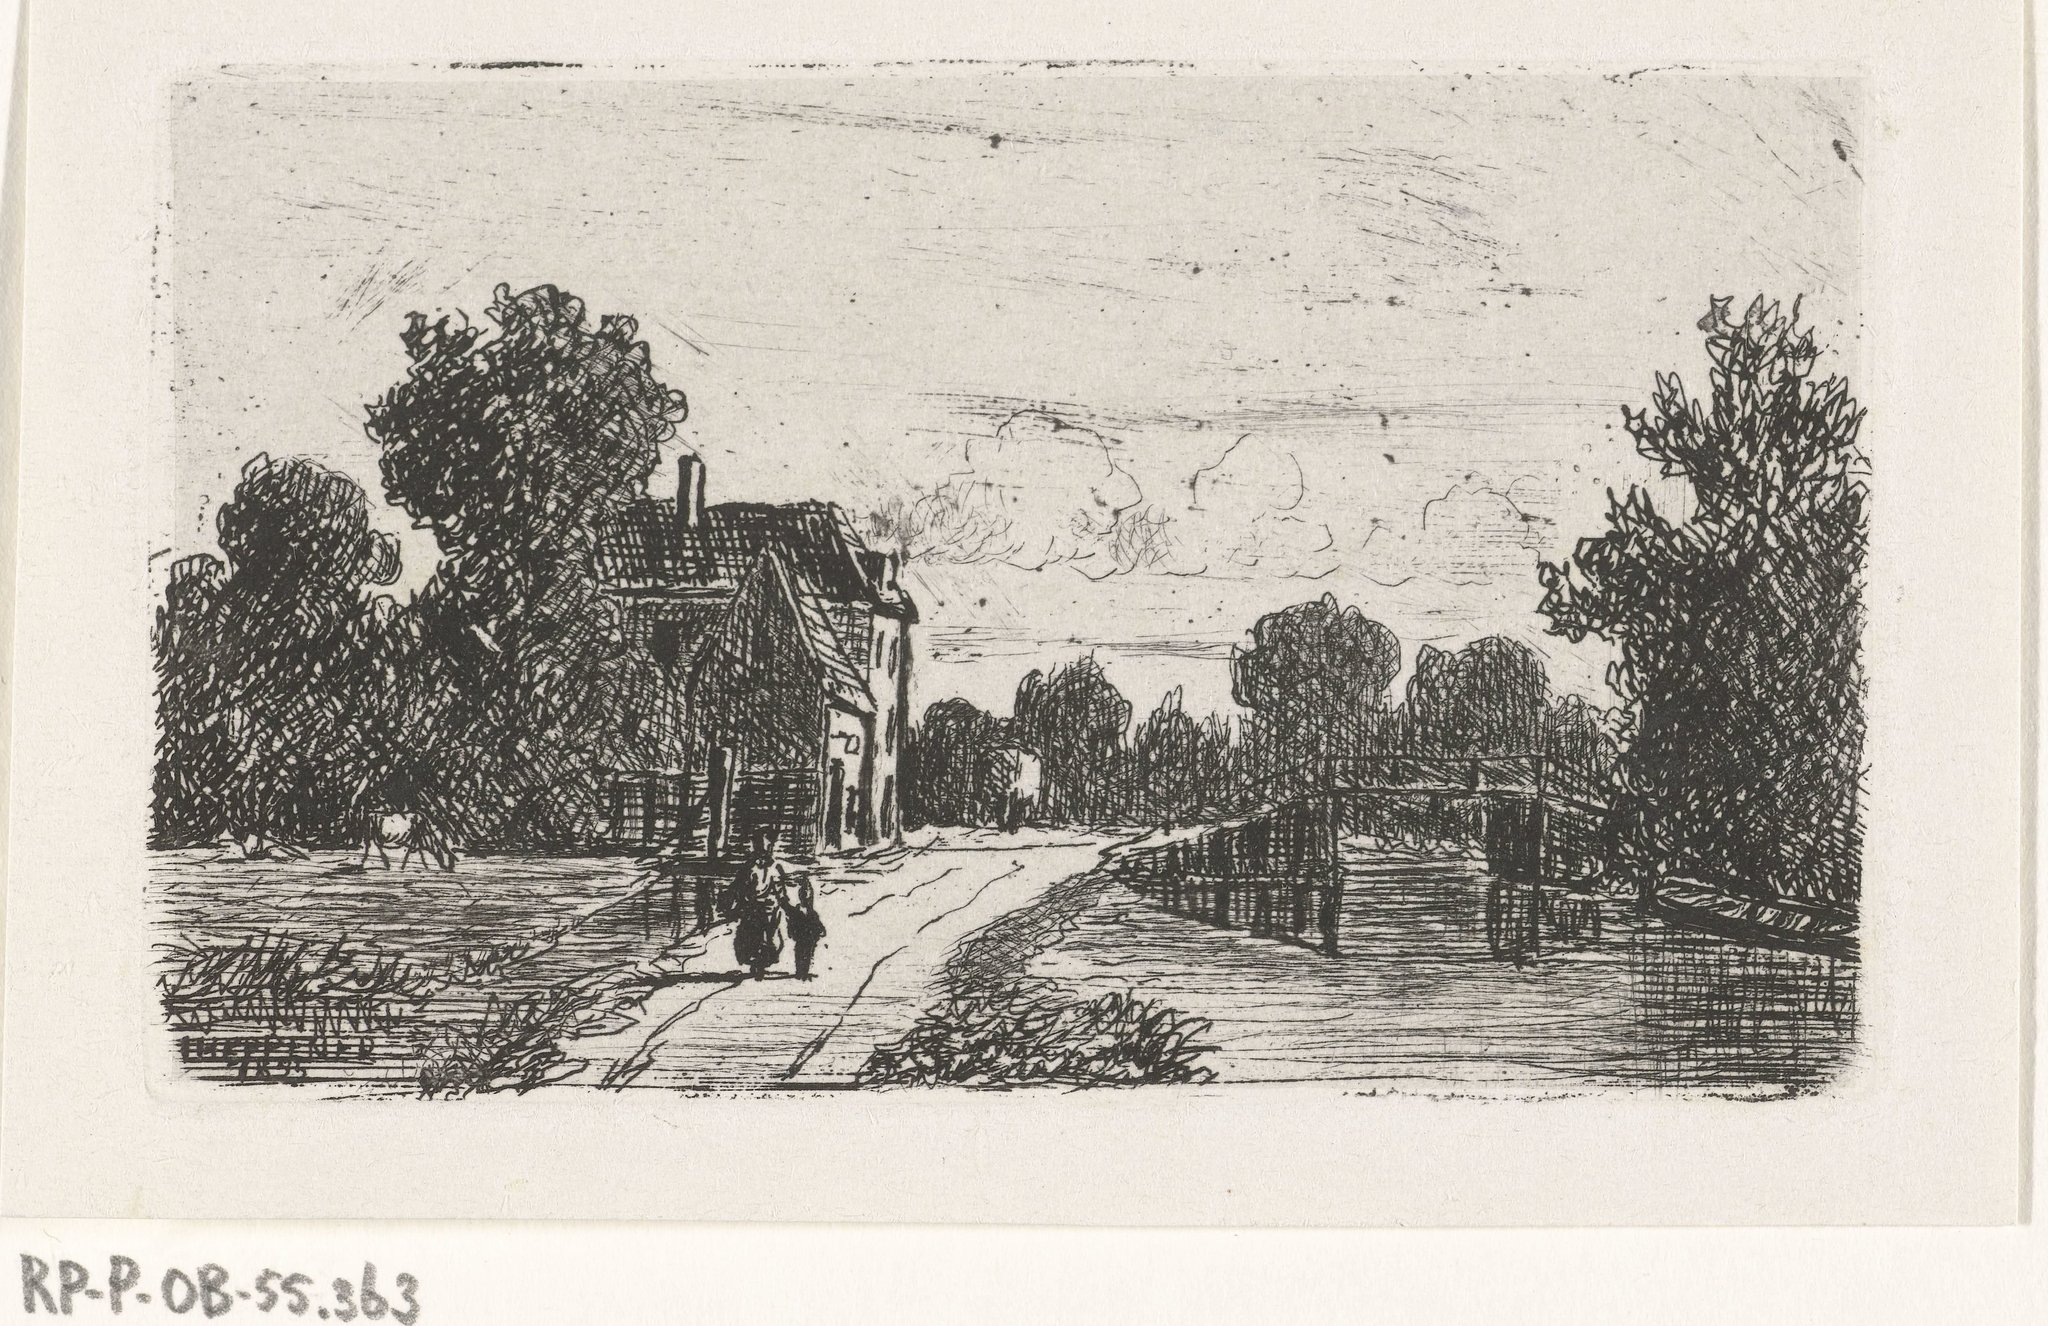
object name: print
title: Landschap met een brug over een vaart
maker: jan heppener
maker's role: print maker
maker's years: 1826-1898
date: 1841-1898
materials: paper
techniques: etching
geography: the hague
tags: landscapes with waters, waterscapes, seascapes (in the temperate zone) (+ landscape with figures, staffage), landscape with bridge, viaduct or aqueduct (+ city(-scape) with figures, staffage)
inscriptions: collector's mark: Lugt 2228